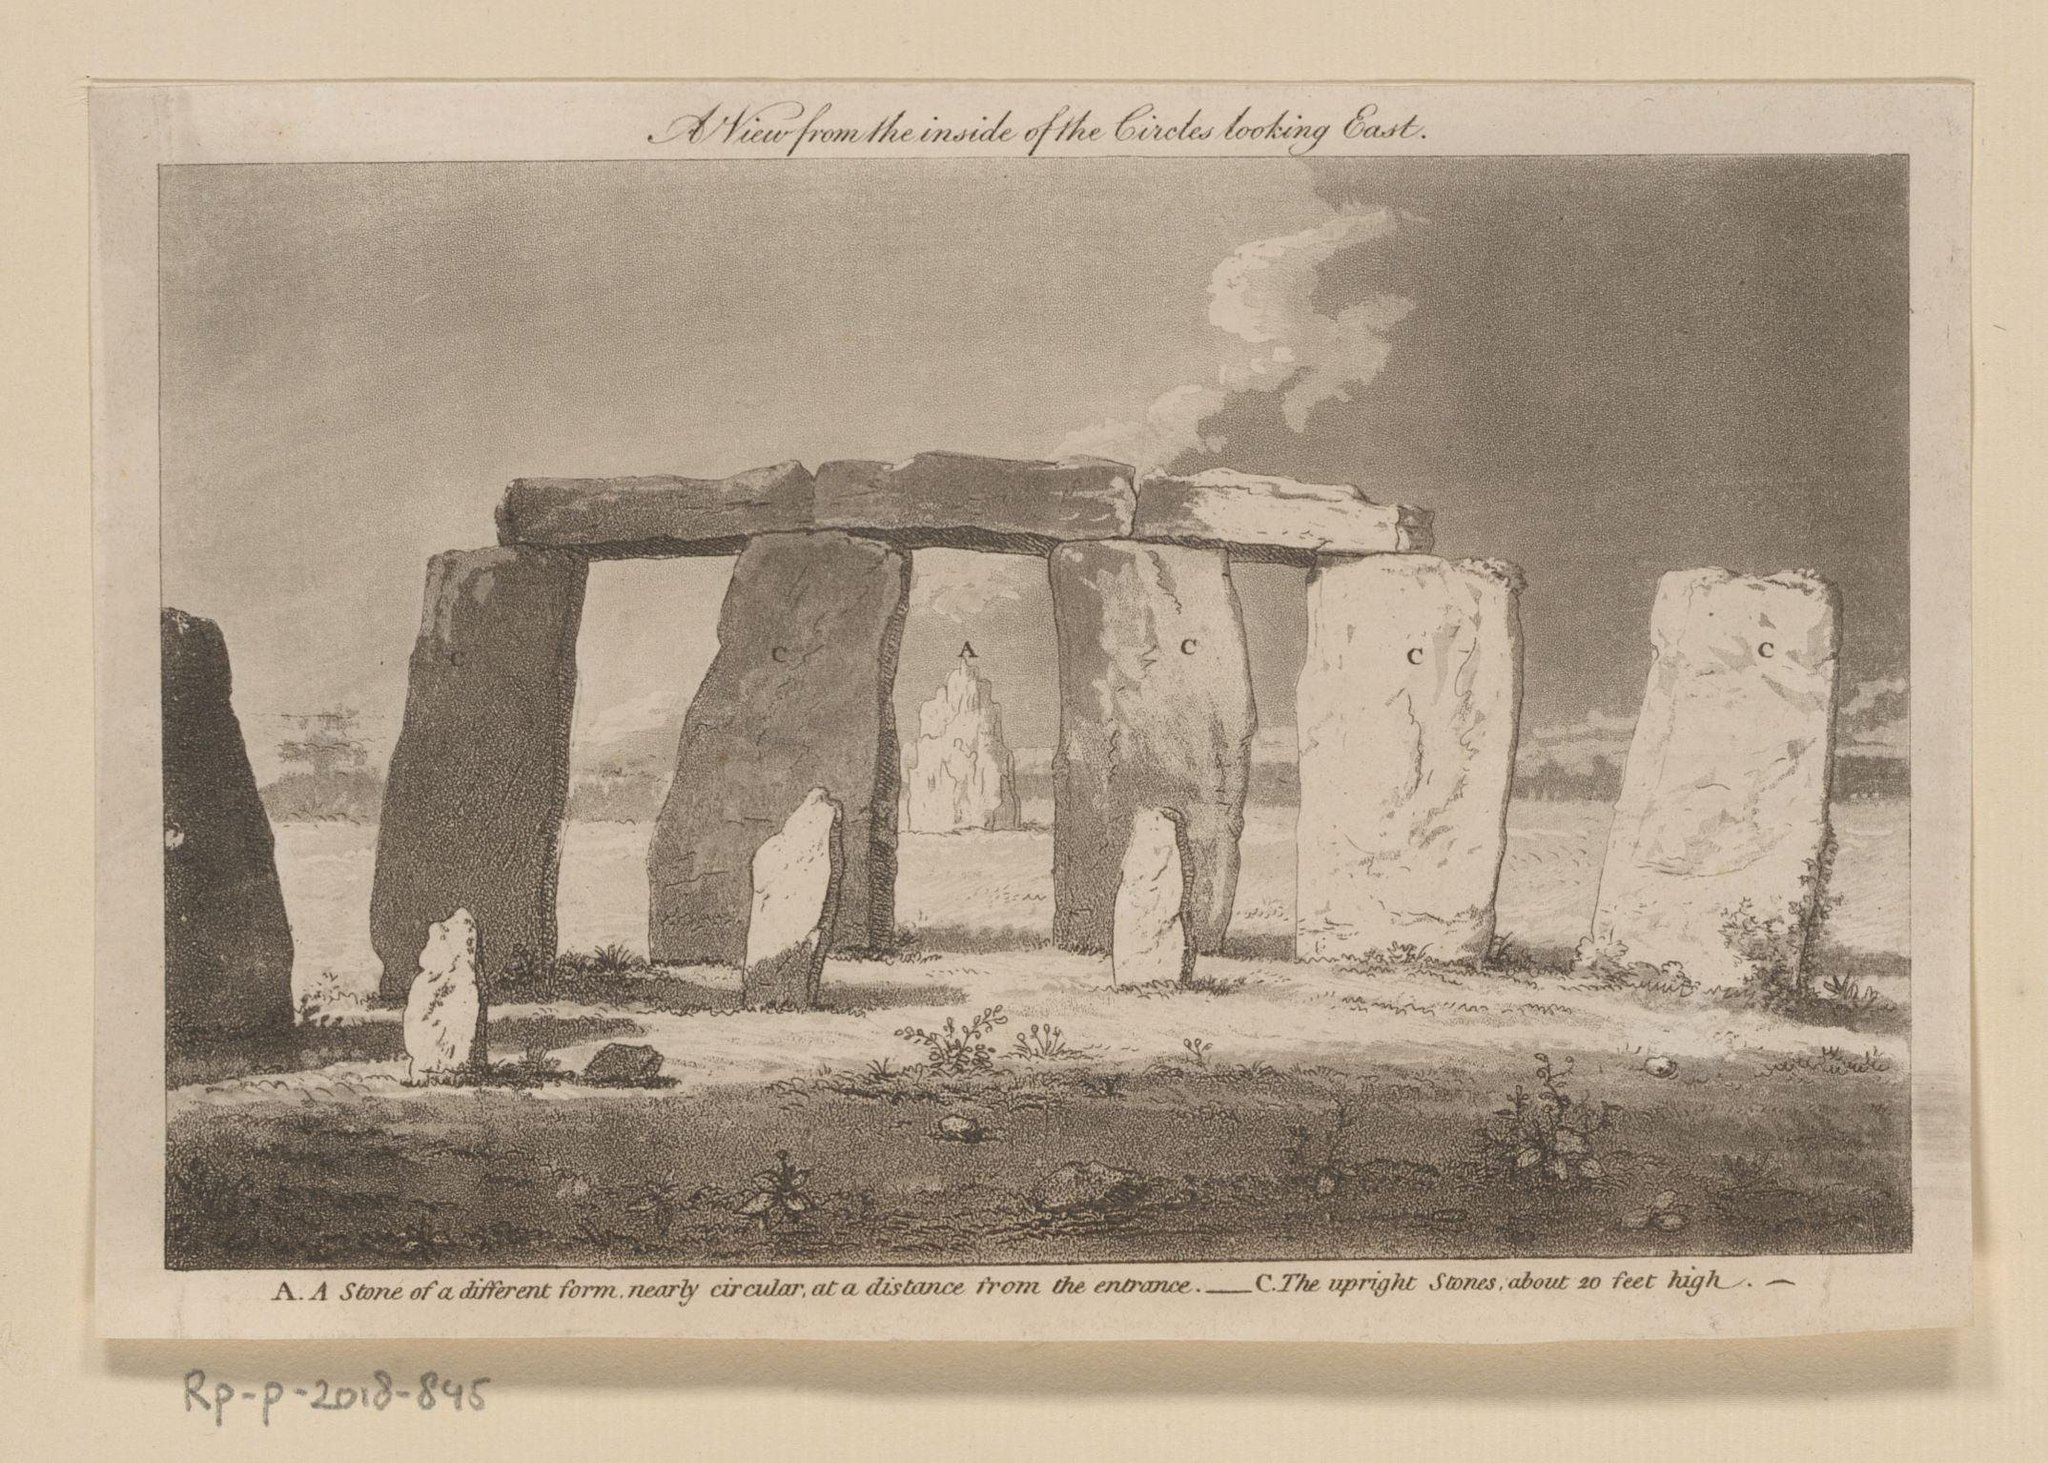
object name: print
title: Gezicht van binnen de Stonehenge naar het oosten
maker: Anonymous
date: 1800-1900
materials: paper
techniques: aquatint, etching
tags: stonehenge